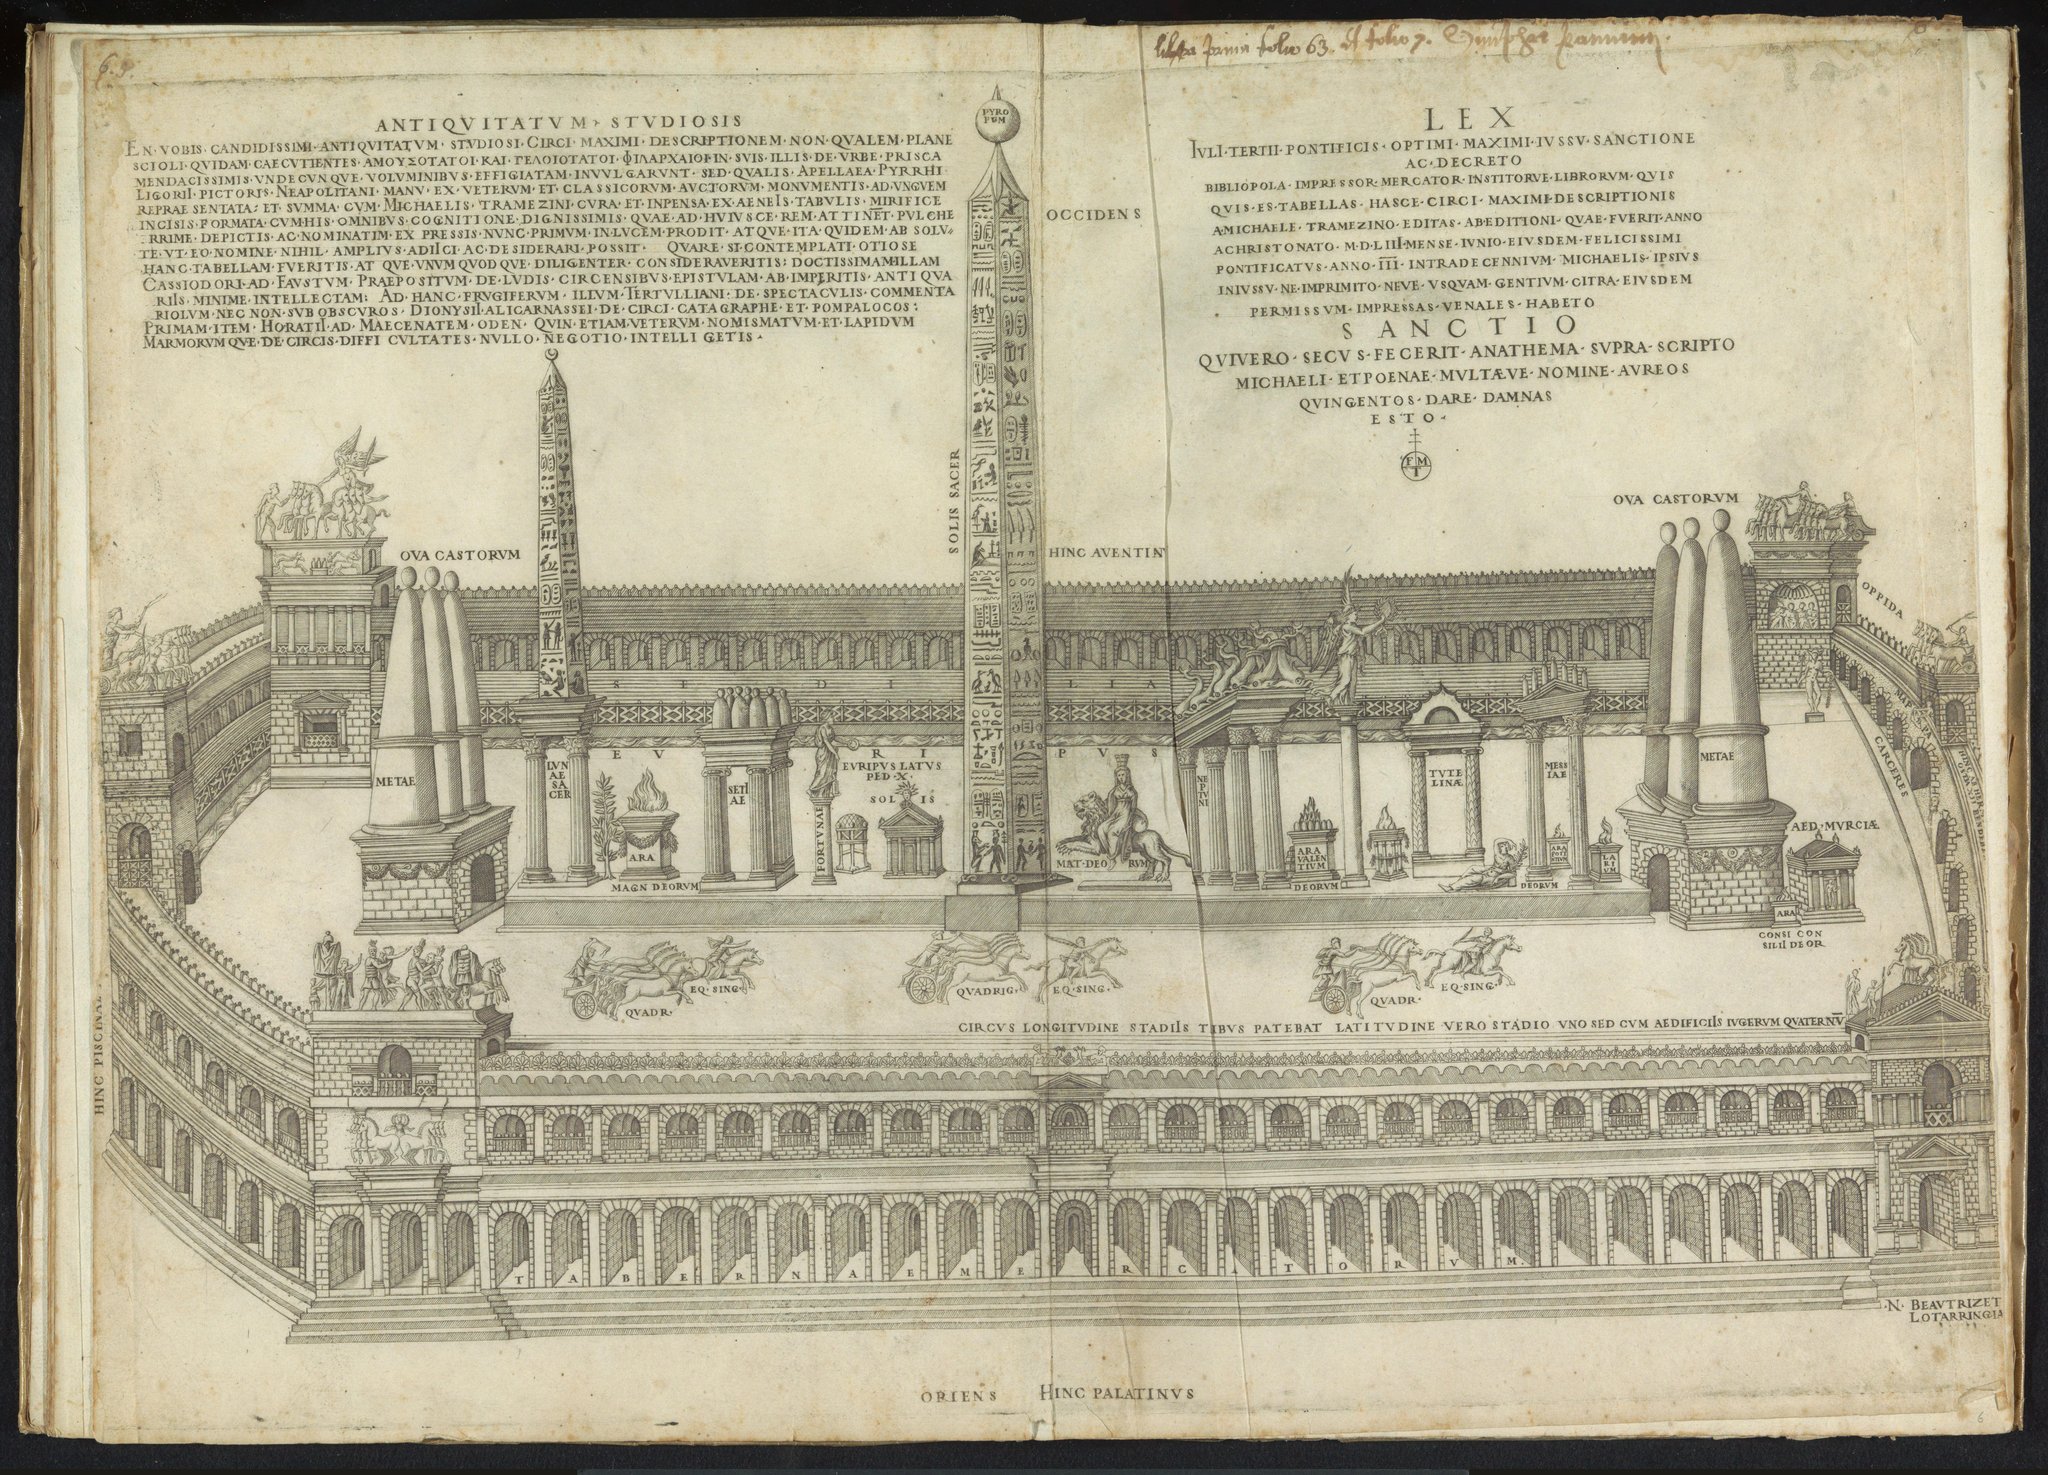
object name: print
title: Antiquitatum studiosis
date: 1553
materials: paper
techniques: engraving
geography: italy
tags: obelisk, needle, horse-racing, rome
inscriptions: inscription: ‘[...] folio 63 - folio 7. [...]’, number: ‘6’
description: Deze prent behoort tot het prentcorpus dat bekend staat als de ‘Speculum Romanae Magnificentiae’ (‘Spiegel van Romeinse pracht’). Dit corpus, bestaande uit prenten met voorstellingen van kunstwerken en gebouwen uit het antieke en het moderne Rome, vond zijn oorsprong bij uitgevers Antonio Salamanca en Antonio Lafreri. Deze twee buitenlandse uitgevers bundelden hun krachten te Rome in de periode 1553-1563. Hun prenten werden al snel razend populair bij toeristen en verzamelaars, die de prenten individueel of in grote groepen aanschaften. Grote groepen Speculum-prenten werden vaak op aanvraag samengebonden in albums. Er zijn verschillende Speculum-albums overgeleverd die allemaal verschillen van inhoud. Tussen 1573 en 1577 gaf Antonio Lafreri een speciale titelpagina uit (met de titel ‘Speculum Romanae Magnificentiae’) die mensen voor hun verzamelingen konden voegen. Het overlijden van Lafreri in 1577 betekende niet het einde van het corpus. Een groot deel van de koperplaten ging over op Claudio en Stefano Duchetti. De rest raakte verspreid over verschillende andere uitgevers. De populariteit van de Speculum-prenten wist nog geruime periode uitgevers te inspireren tot het laten maken van kopieën en het toevoegen van nieuwe prenten aan het corpus.